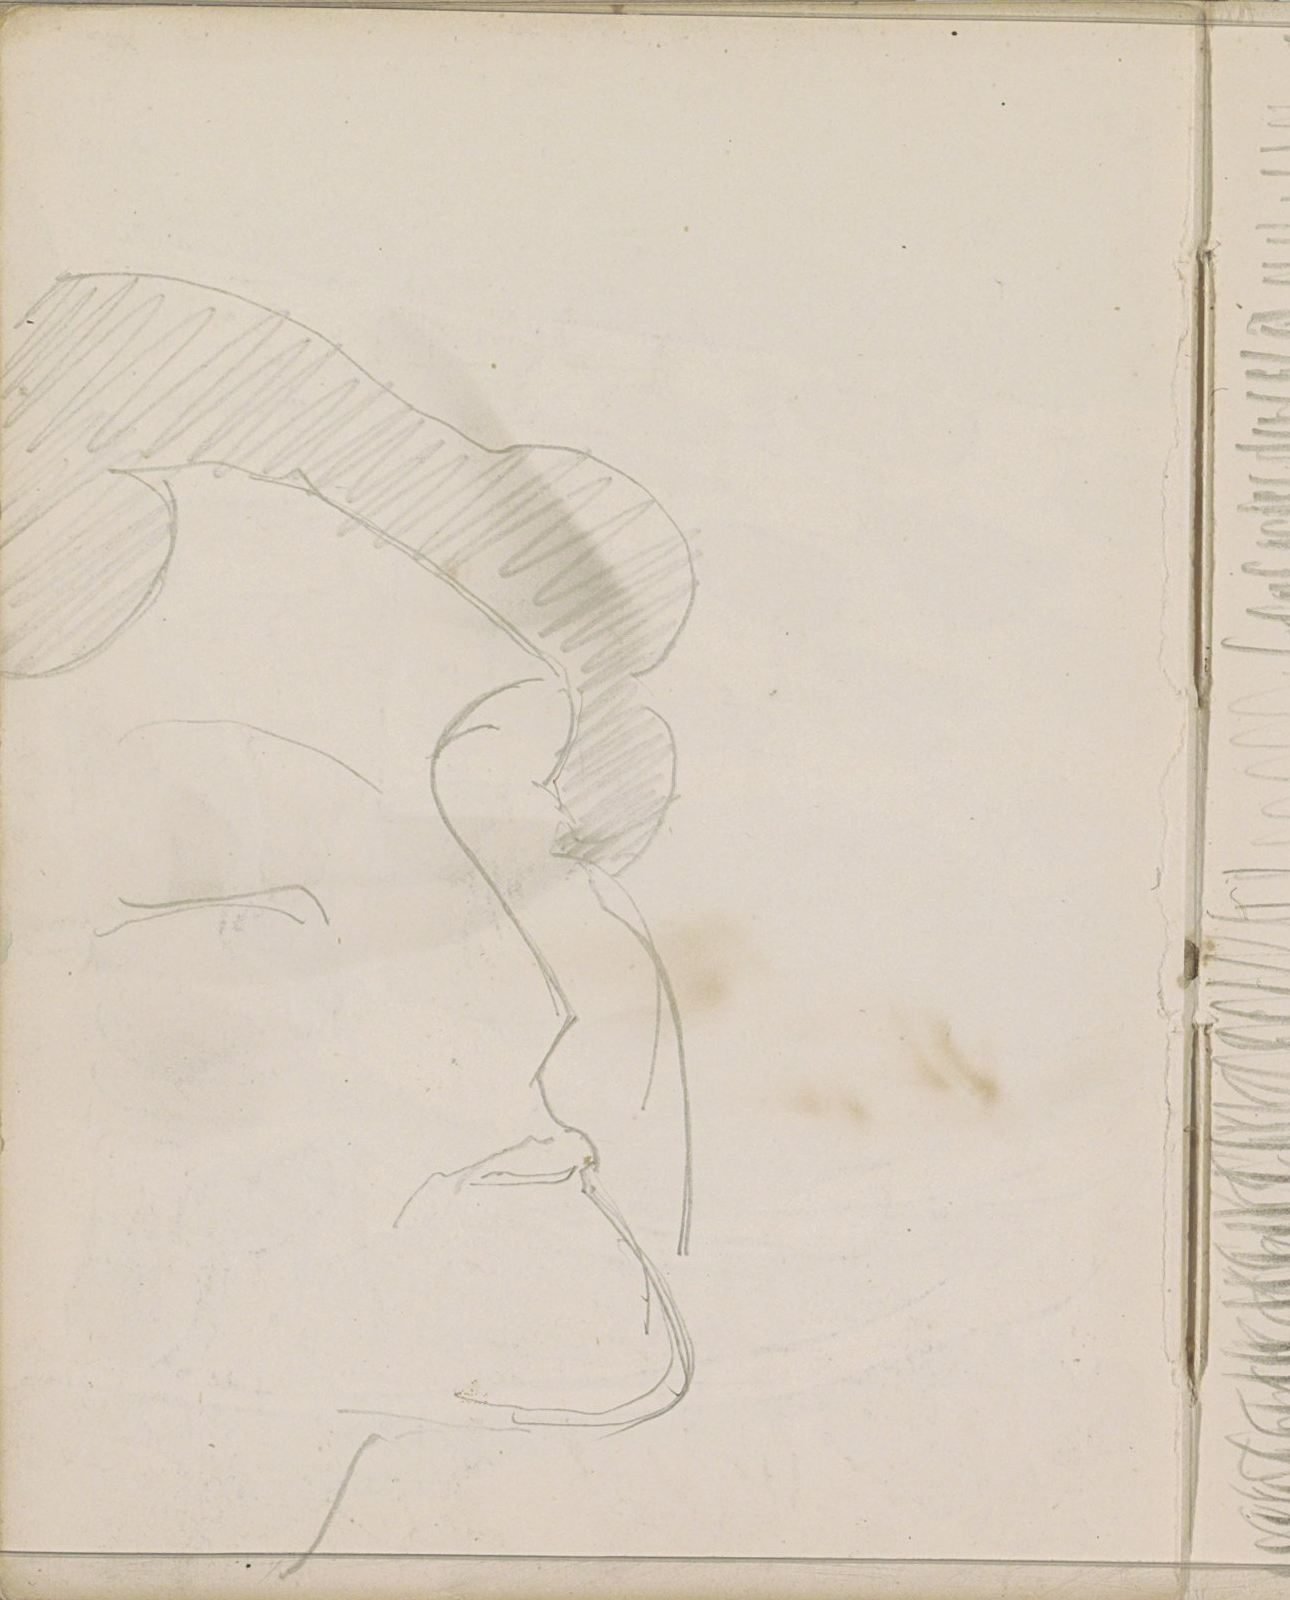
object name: sketchbook leaf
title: Hoofd van een vrouw met gesloten ogen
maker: reijer stolk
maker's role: draughtsman, print maker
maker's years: 1896-1945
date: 1916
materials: paper, pencil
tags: eyes closed, head (human) - aa - female human figure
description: Blad 67 verso uit een schetsboek met 72 bladen.